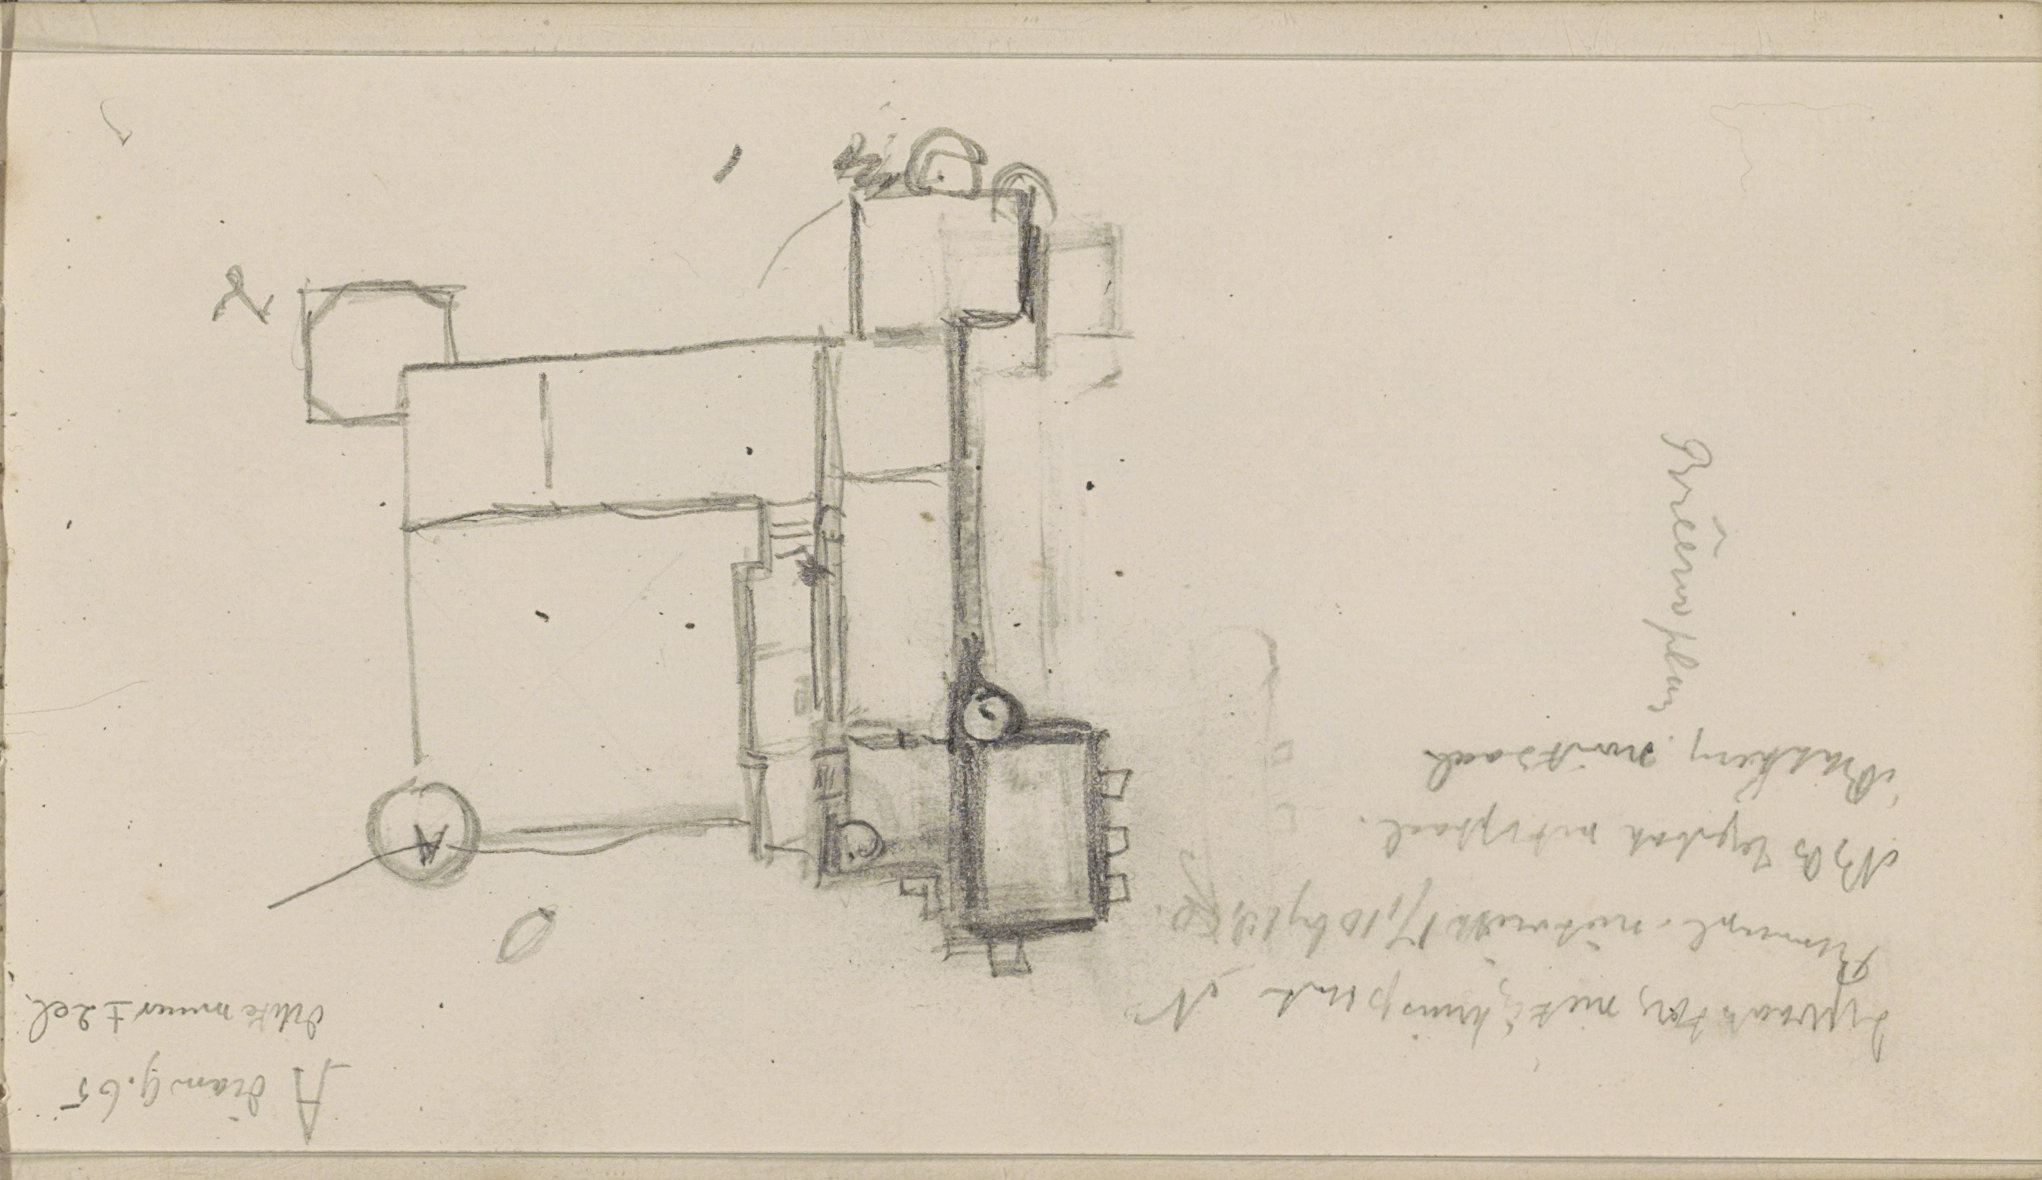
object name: sketchbook leaf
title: Plattegrond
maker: isaac gosschalk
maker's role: draughtsman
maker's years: 1838-1907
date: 1866-1868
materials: paper, pencil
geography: amsterdam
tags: plan ~ architecture, amsterdam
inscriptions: annotation: ‘A dam 9.65/ dikte muur [...]/ [...]’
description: Blad 35 recto uit een schetsboek met 67 bladen.